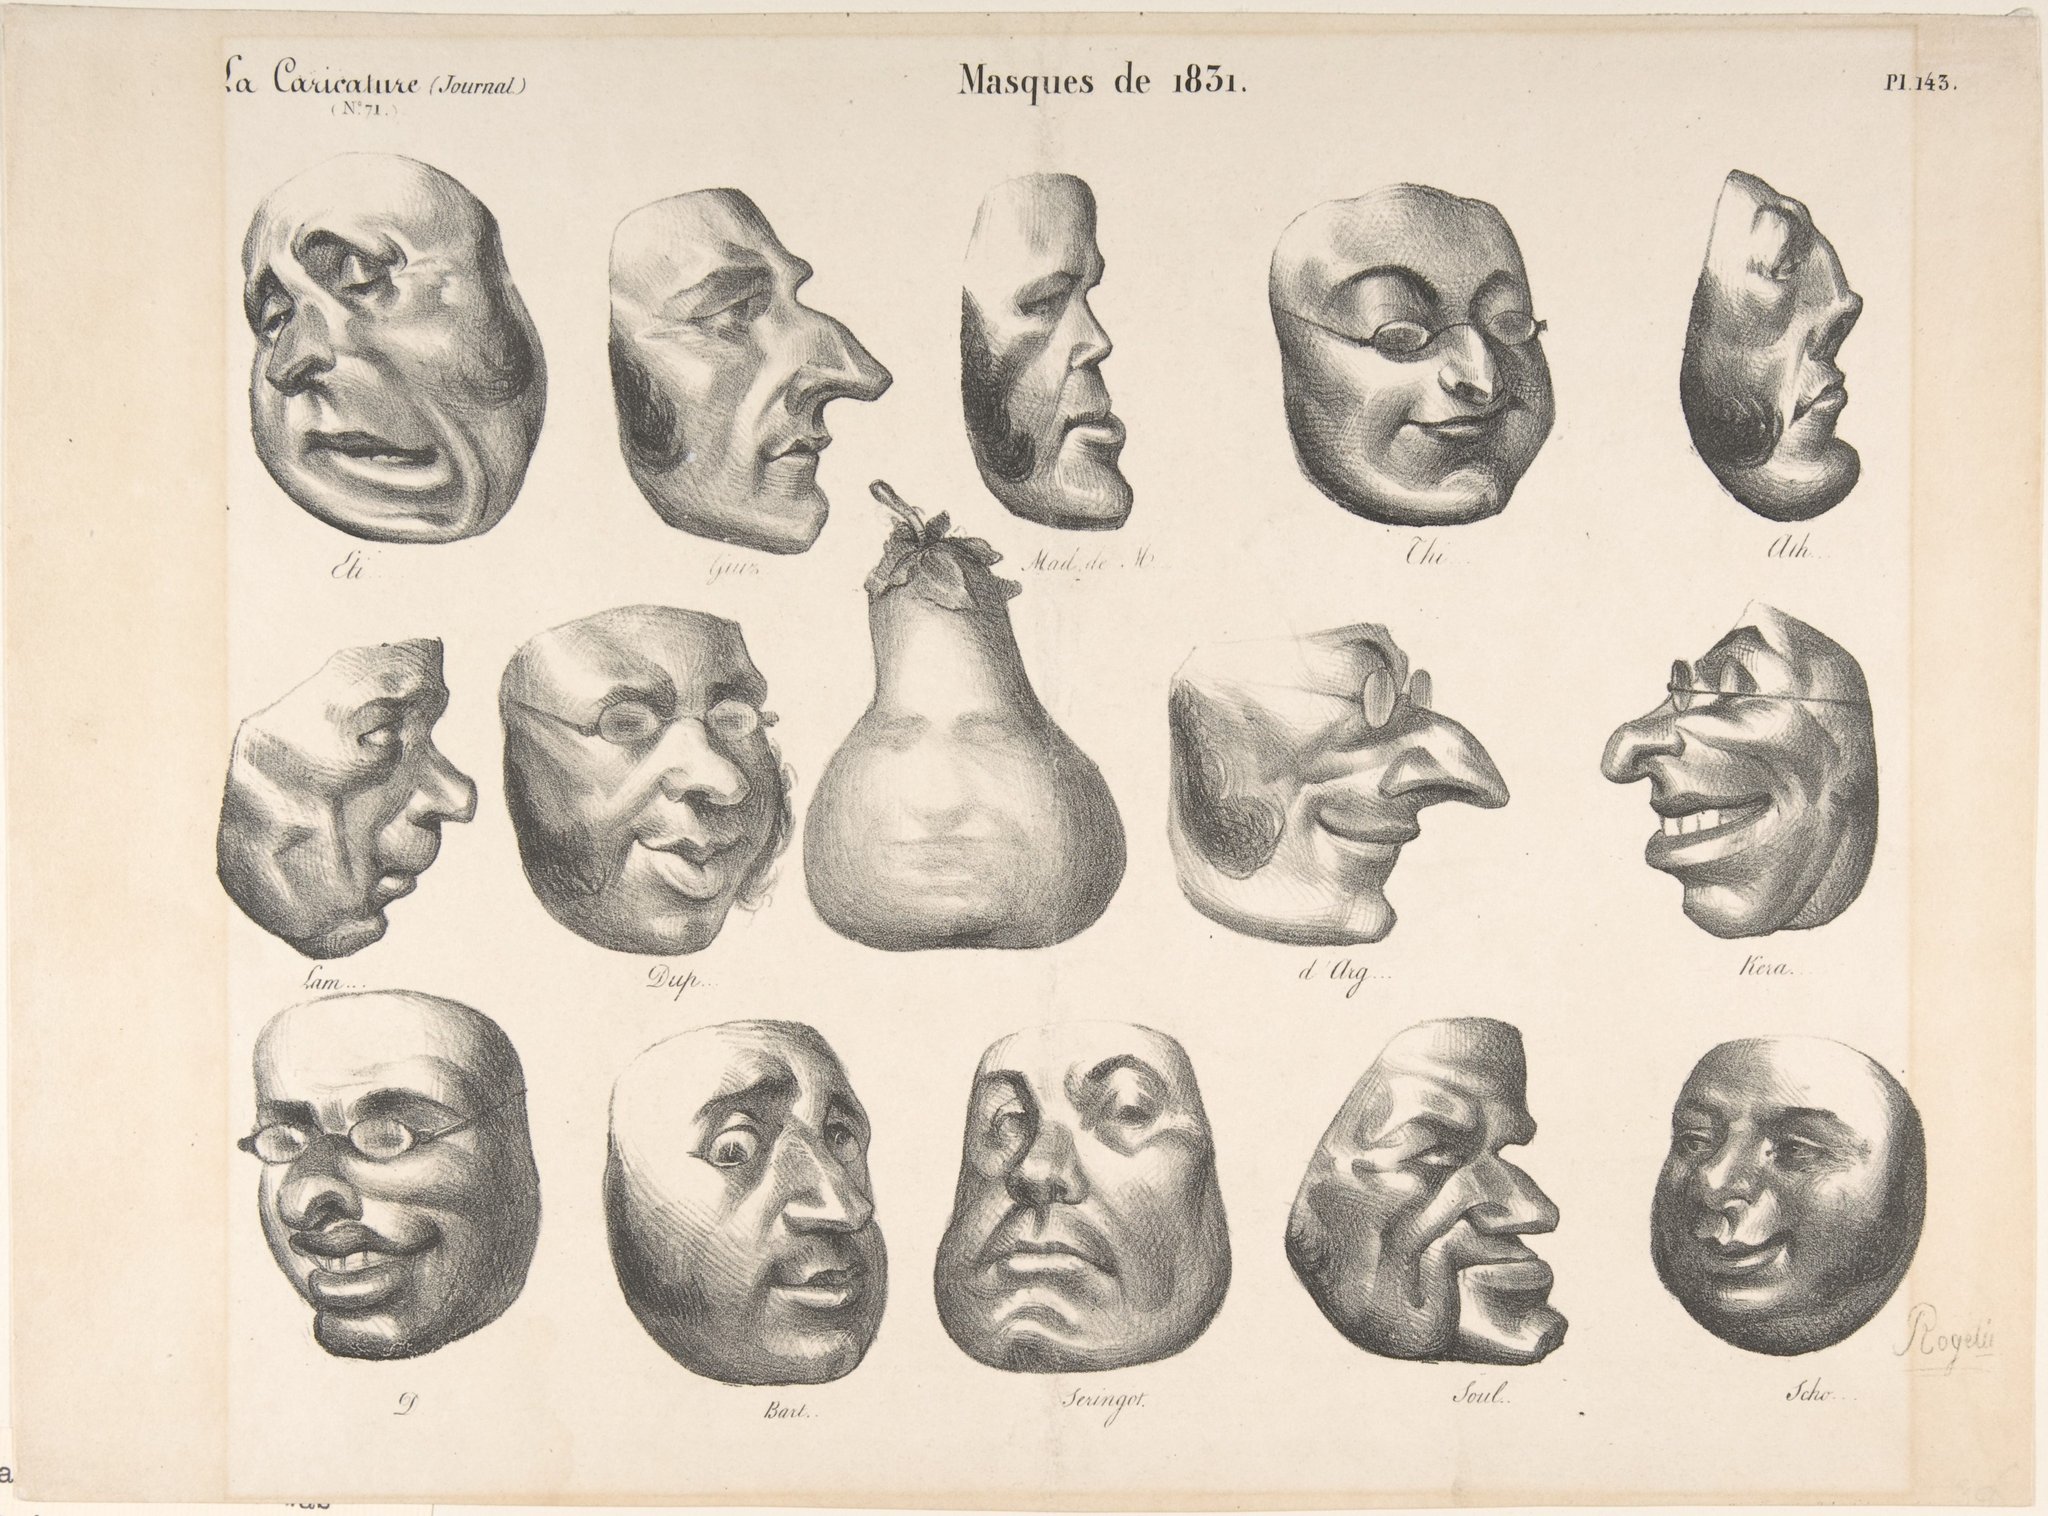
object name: print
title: Masks of 1831, published in La Caricature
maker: honoré daumier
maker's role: artist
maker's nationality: french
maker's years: 1808-1879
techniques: lithograph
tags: caricature,politics